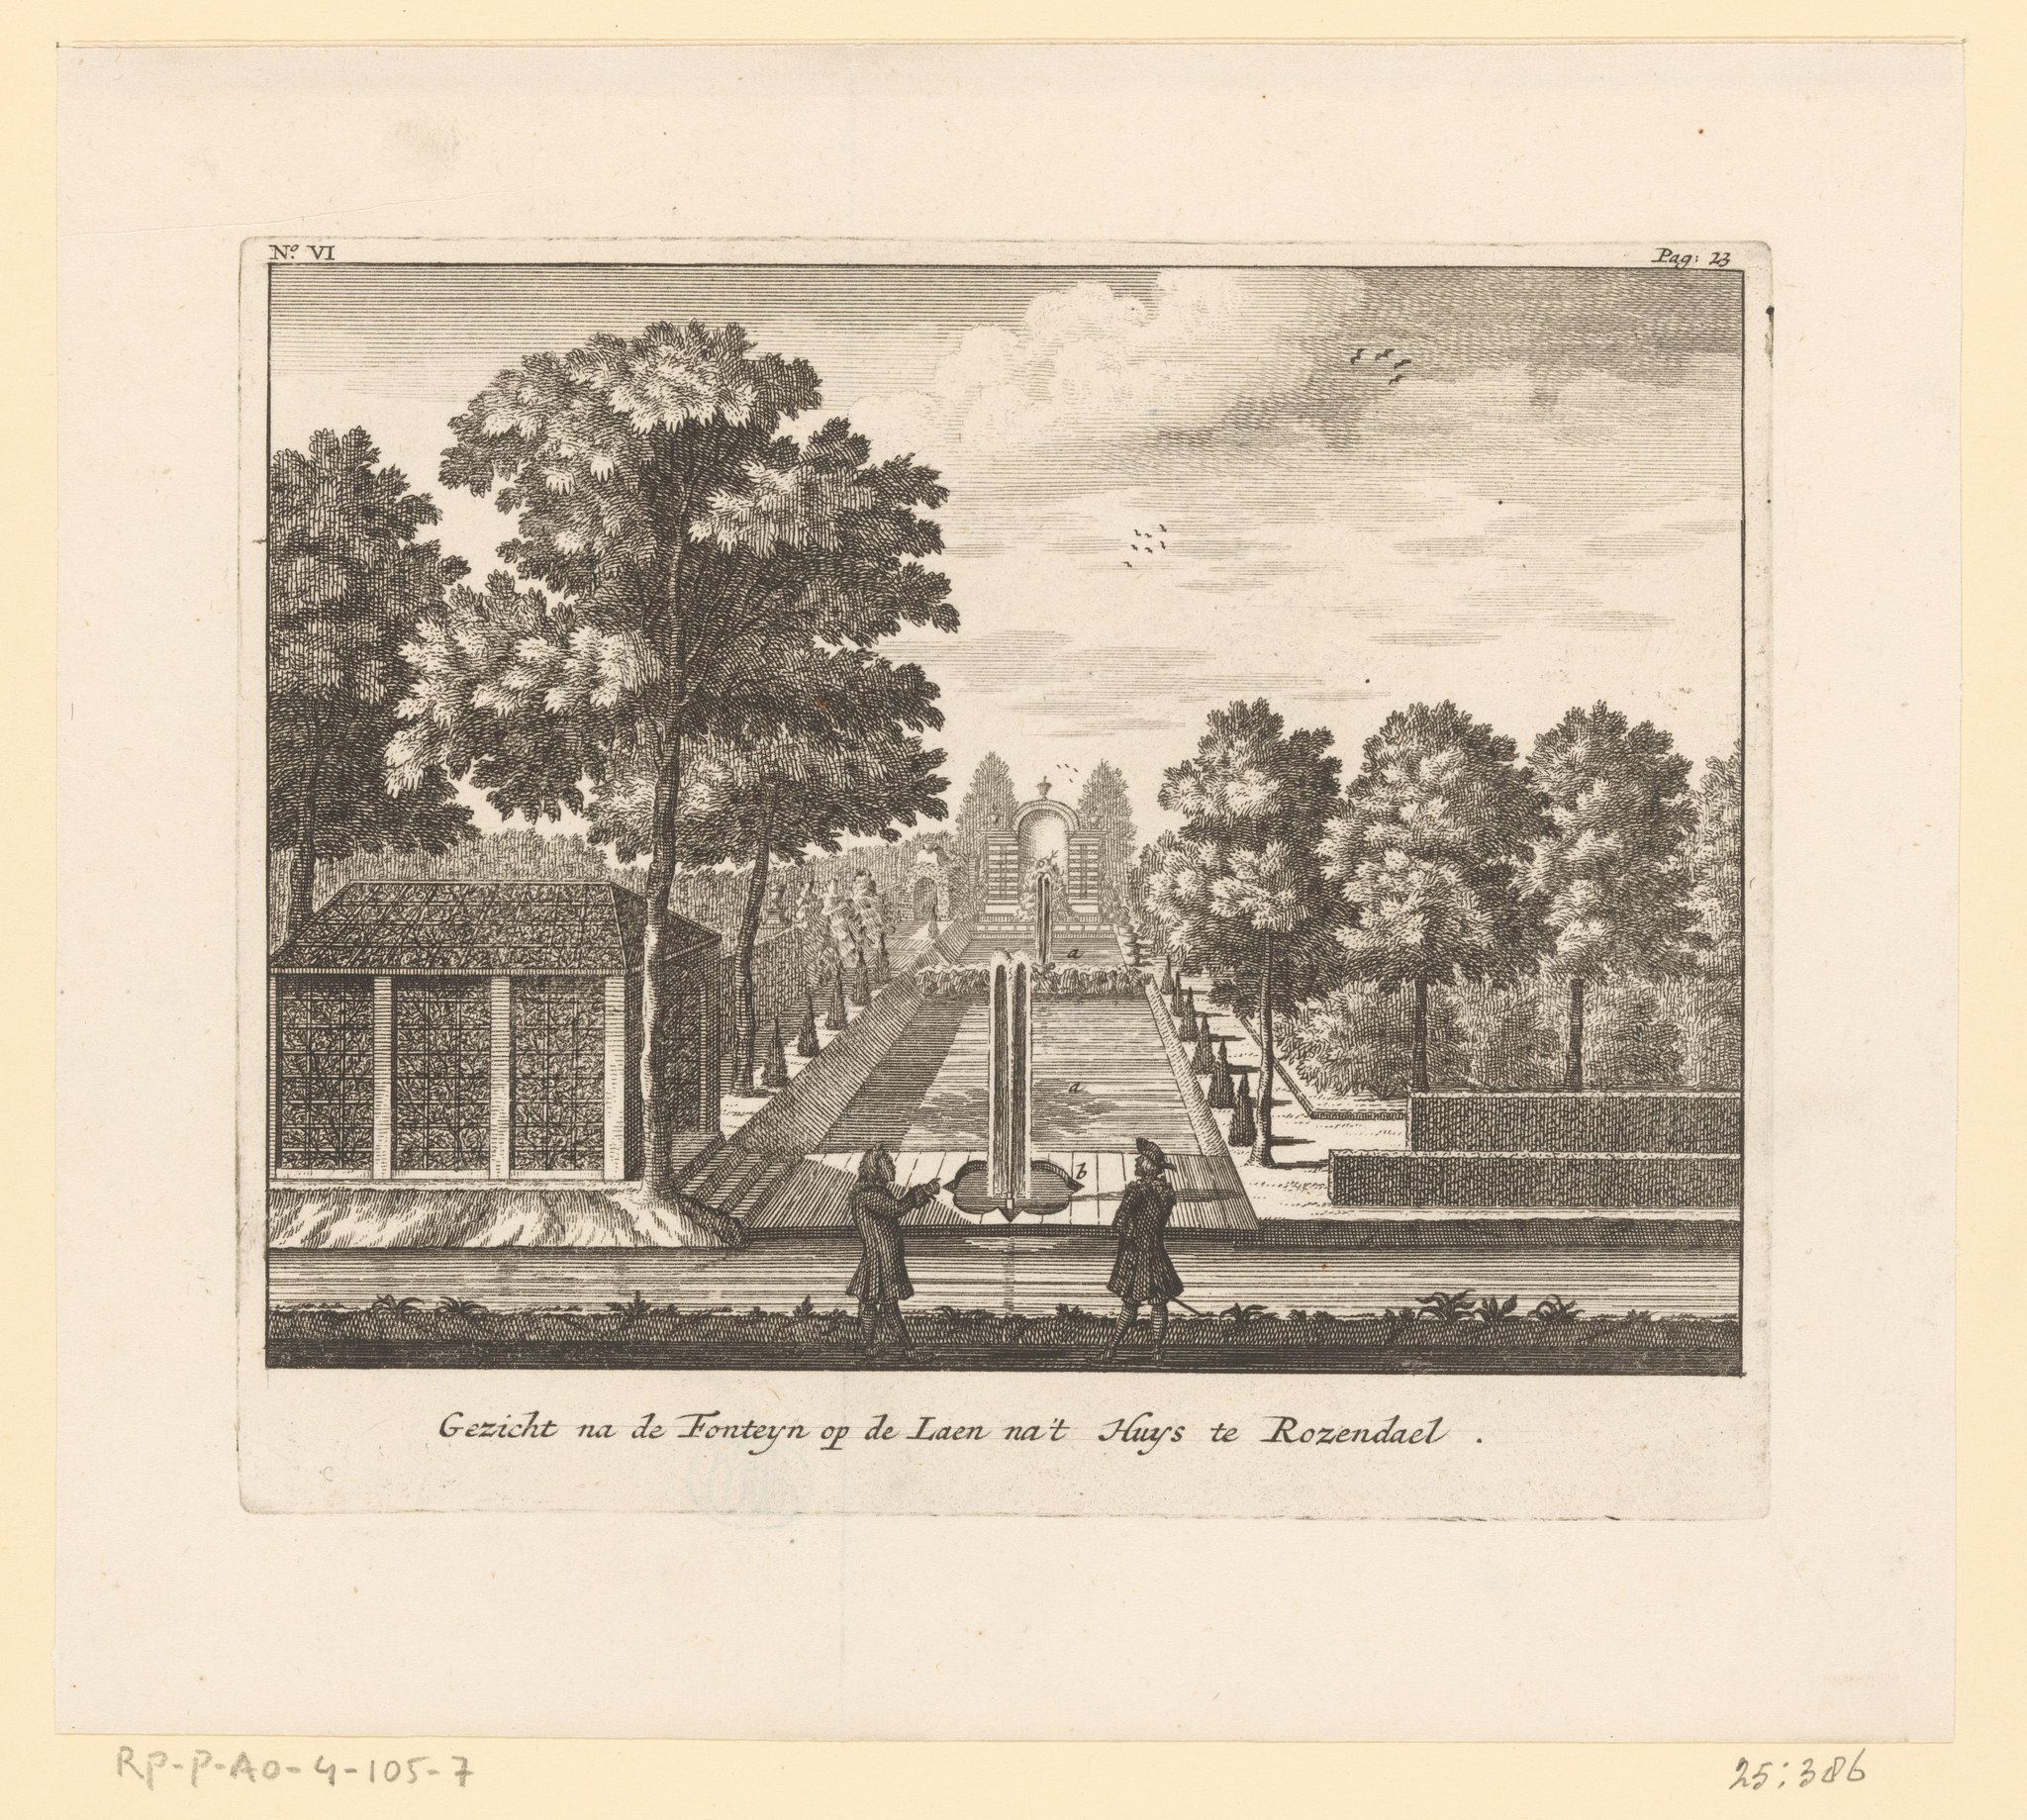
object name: print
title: Gezicht na de fonteyn op de laen na 't Huys te Rozendael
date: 1718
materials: paper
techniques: engraving, etching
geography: amsterdam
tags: castle, garden fountain, french or architectonic garden; formal garden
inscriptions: collector's mark: Lugt 195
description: Prent ook gebruikt in: Outrein, Johannes d’. Wegwyser door de heerlykheid Roosendaal ofte, de Roosendaalsche vermakelykheden. 3e druk. Amsterdam: Gerard van Keulen, 1718.